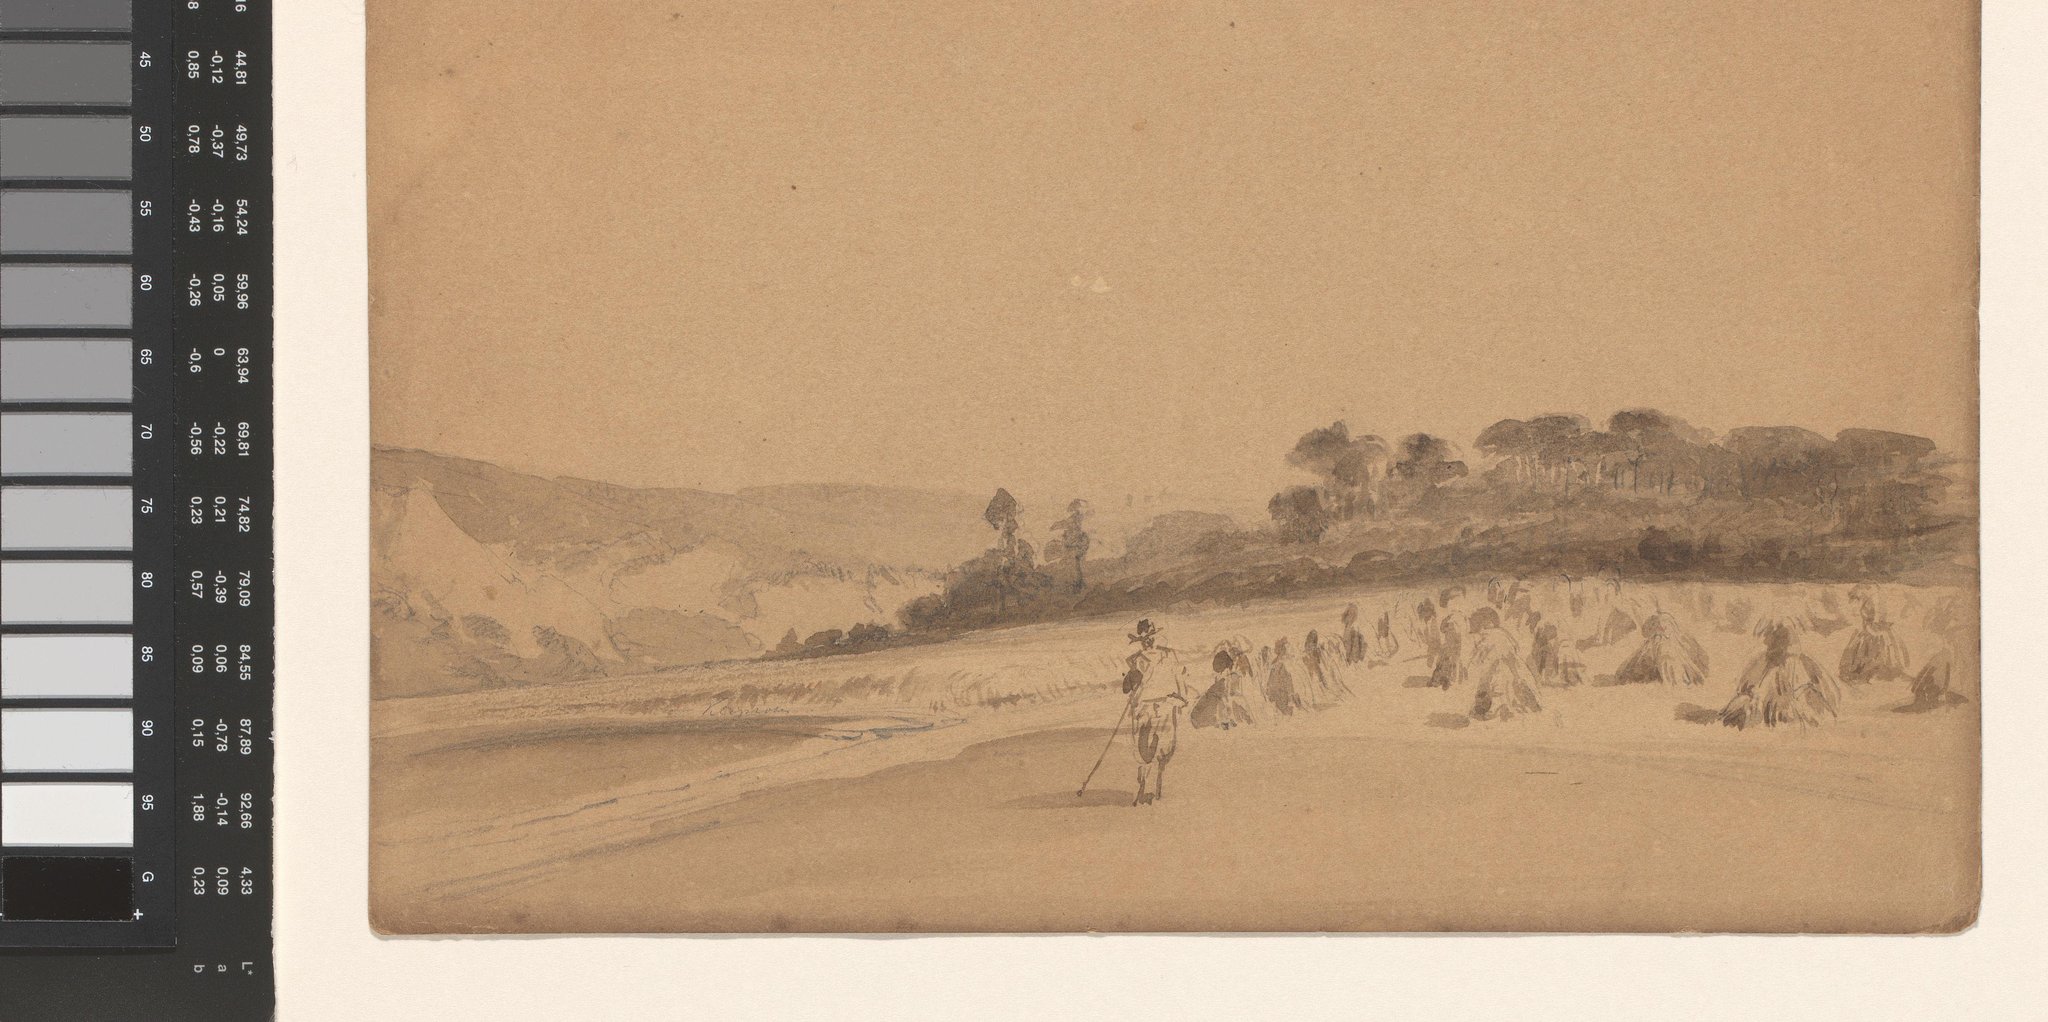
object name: drawing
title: Heuvellandschap met bomen, hooibalen en staande figuur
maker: jan bedijs tom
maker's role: draughtsman, painter, print maker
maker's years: 1813-1894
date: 1823-1894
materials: ink, paper, pencil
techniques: brush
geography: the hague